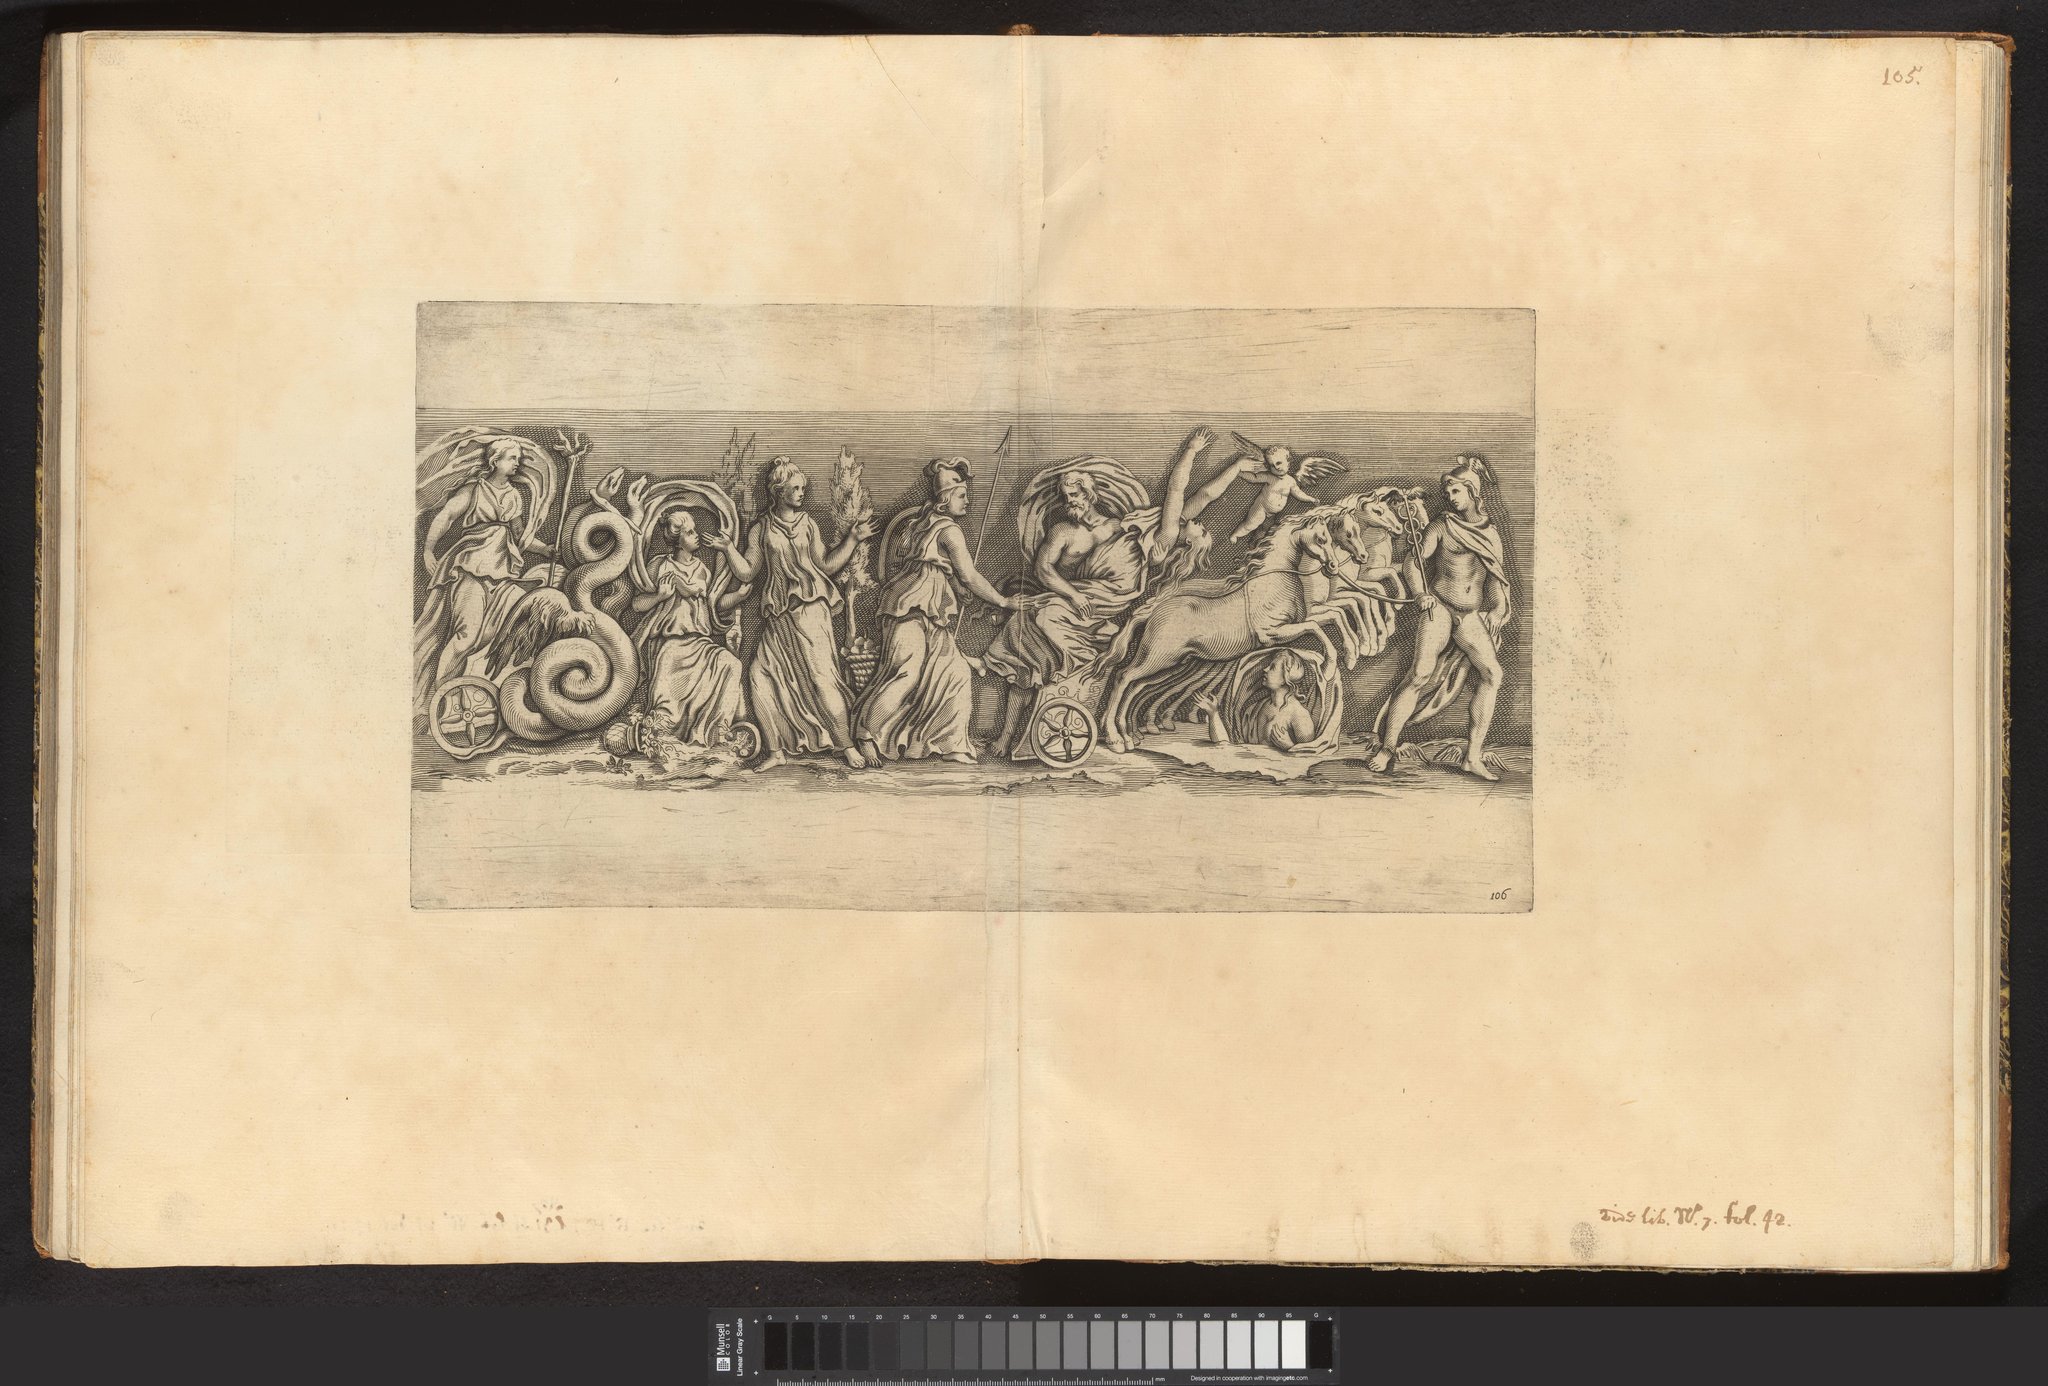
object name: album leaf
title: Galleria Giustiniana del Marchese Vincenzo Giustiniani II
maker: valérien regnard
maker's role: print maker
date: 1636-1647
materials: paper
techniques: engraving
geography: rome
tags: piece of sculpture, reproduction of a piece of sculpture, wagon racing (with horses), cupids: 'amores', 'amoretti', 'putti'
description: Bas-reliëf met putti in paardenwagens. Midden onder het wapenschild van Vincenzo Giustiniani. Prent maakt deel uit van een album met een serie prenten naar de sculpturen in de verzameling in de Galleria Giustiniani te Rome.